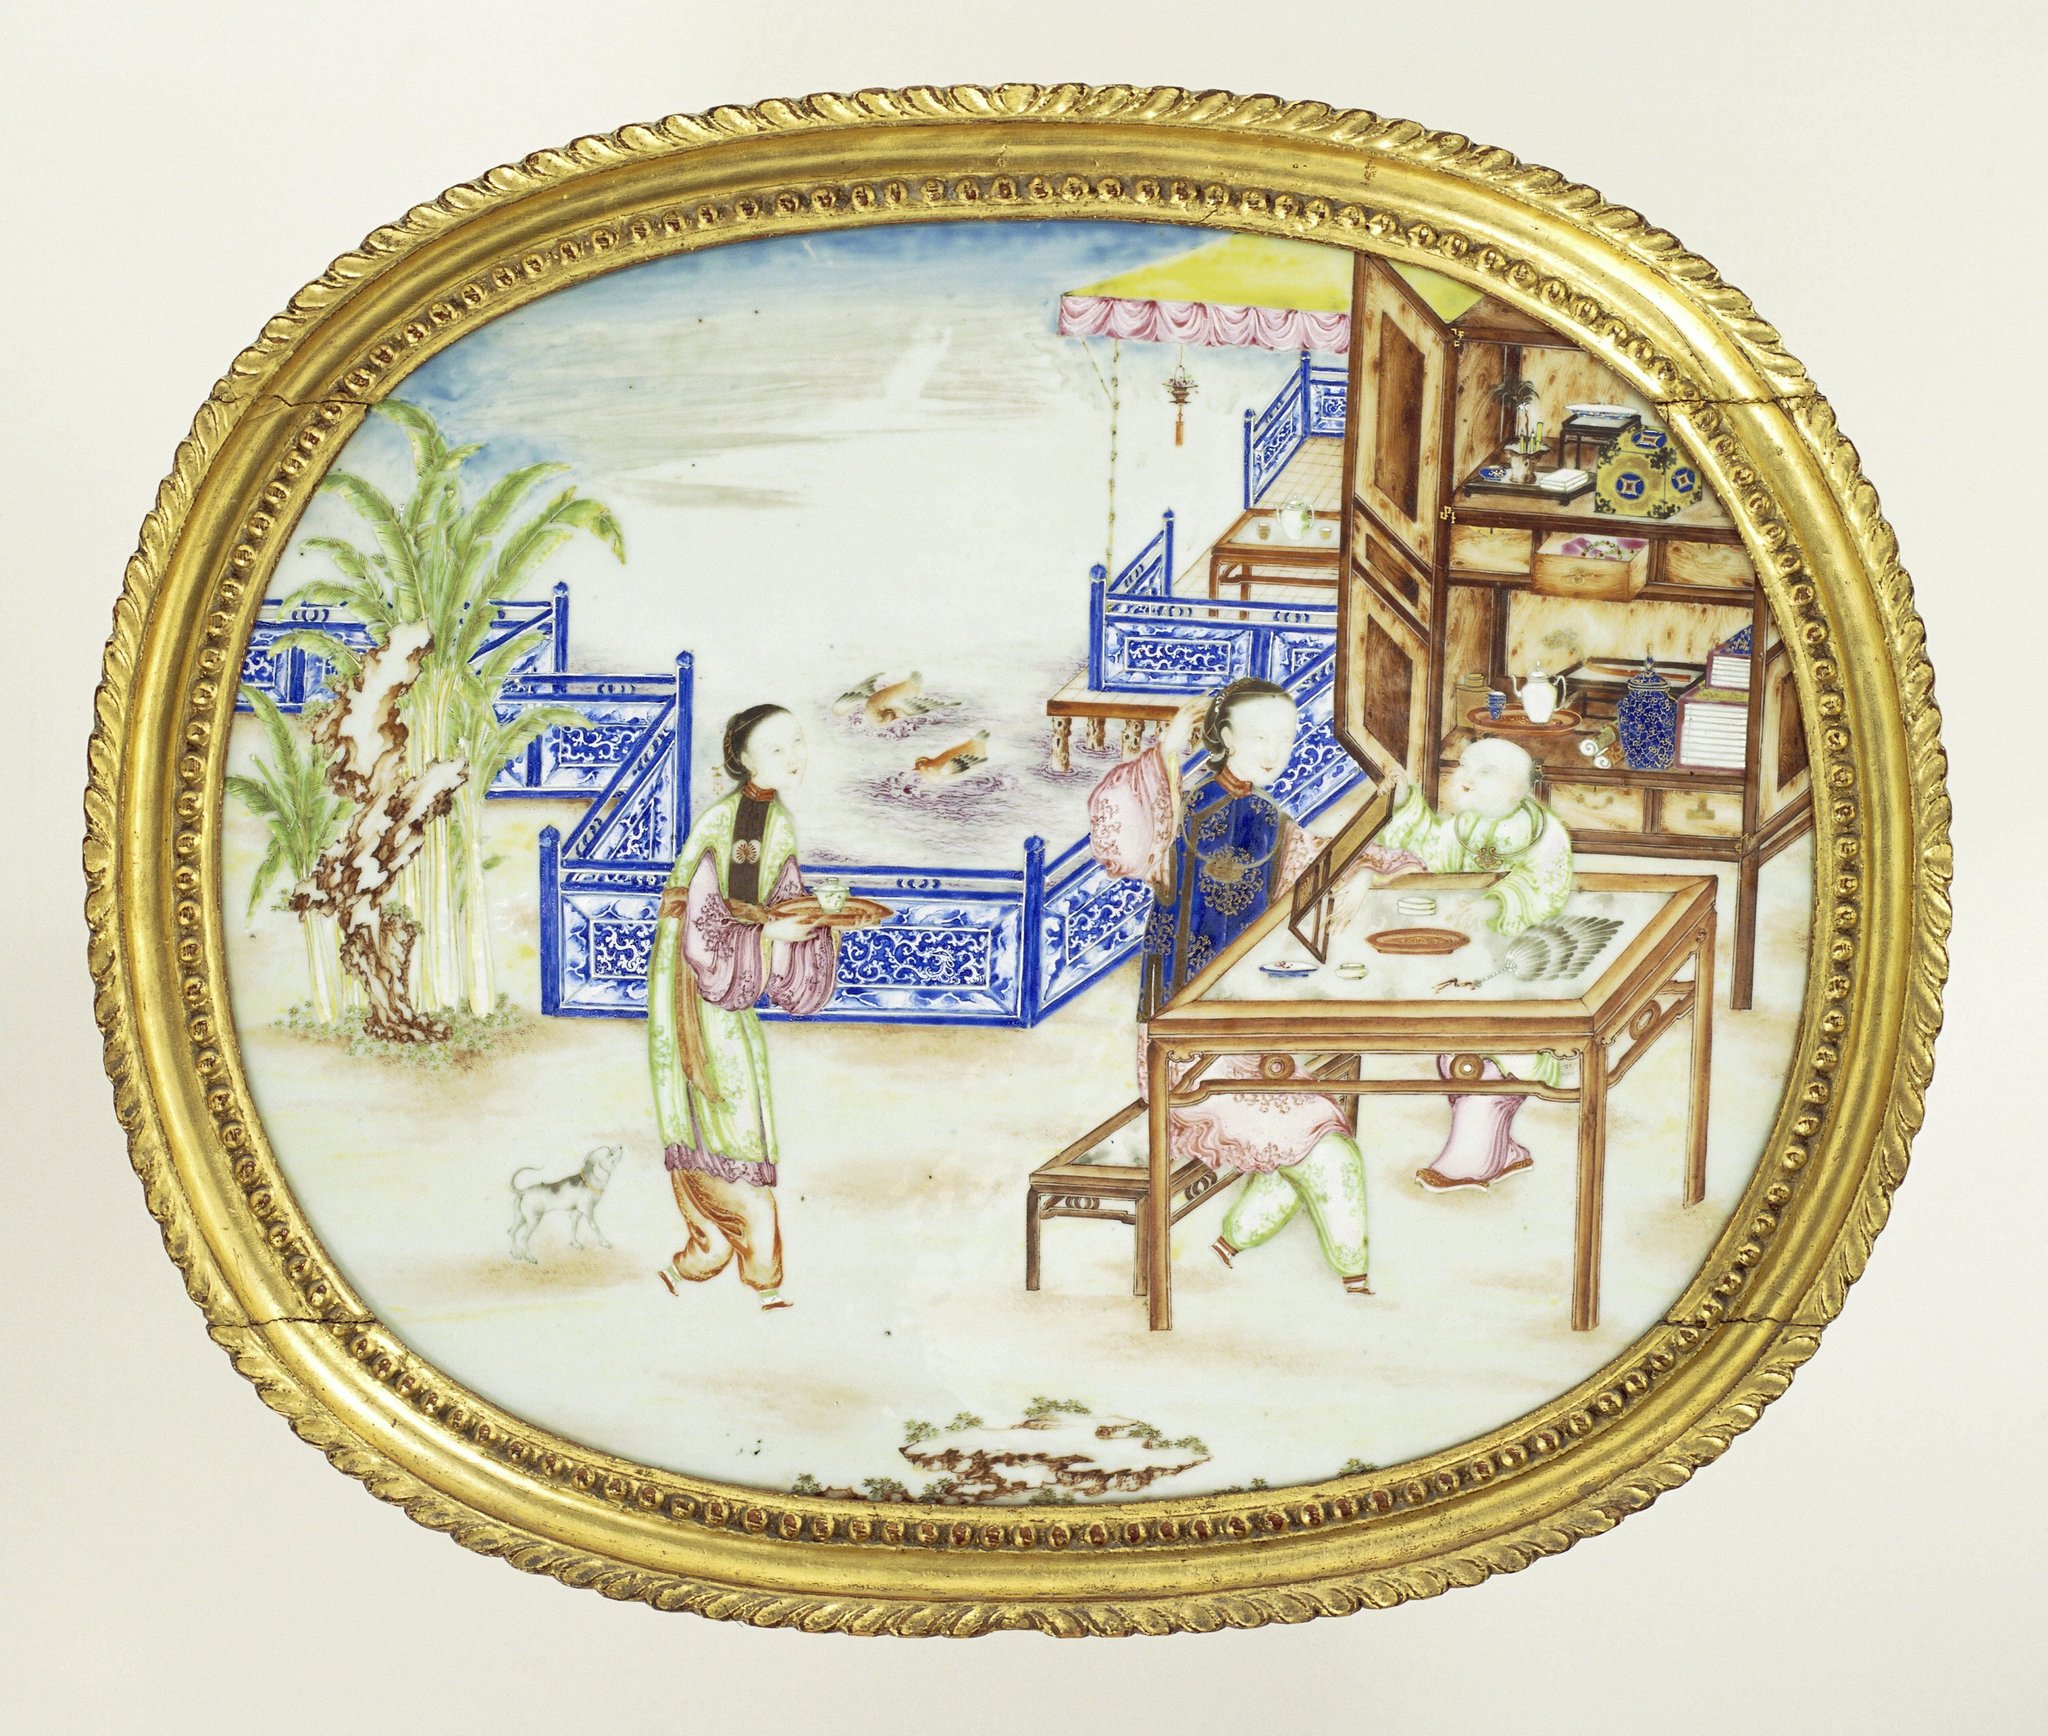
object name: plate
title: Oval panel with a woman, her servant and a boy on a fenced terrace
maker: Anonymous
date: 1770-1775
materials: glaze, gold, paint, porcelain, wood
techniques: firing, forming, gilding, vitrification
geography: china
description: Ovale plaque van porselein, beschilderd op het glazuur in blauw, rood, roze, groen, geel, paars, bruin, zwart en goud. De voorstelling toont een vrouw aan een tafel met objecten. De jongen houdt een spiegel vast, waarin ze zichzelf bekijkt. Naast hen komt een bediende aanlopen met een dienblad, achter haar een hond. Op de achtergrond een kast met kostbaarheden en objecten van een geleerde. Op het terras een bananenplant en een rots. Om het terras een vijver met twee pekingeenden. Originele vergulde lijst. Porselein met emailkleuren.